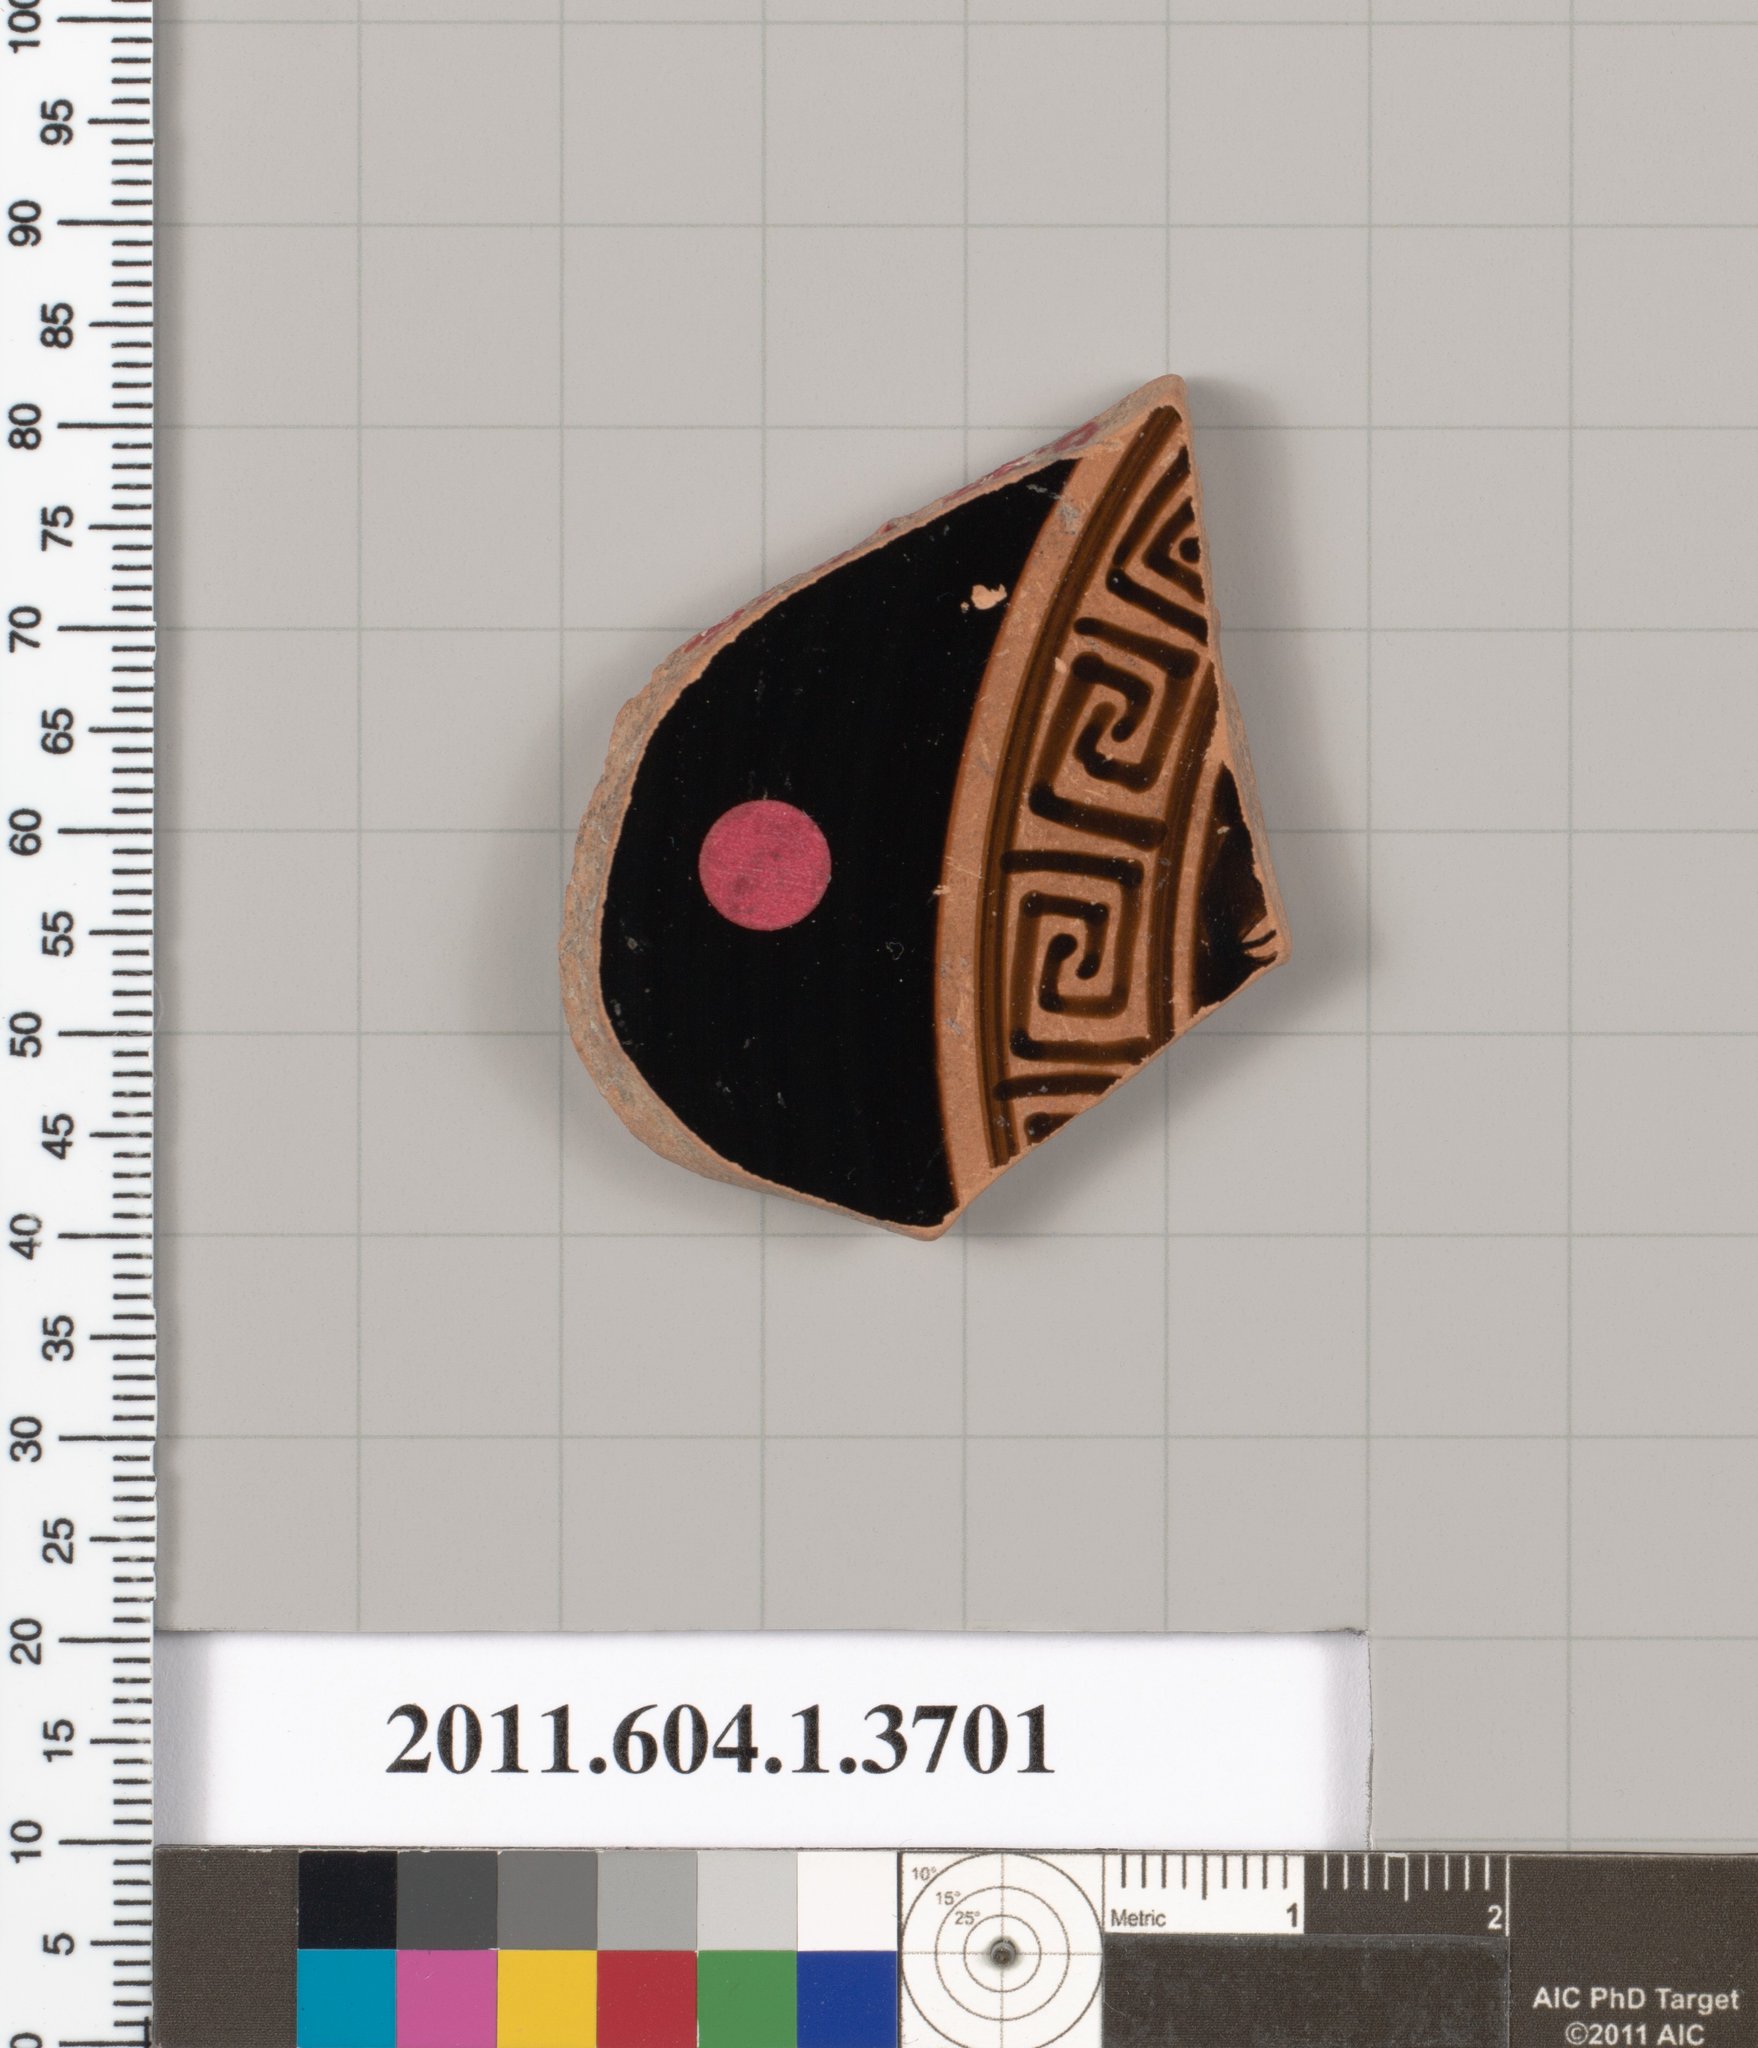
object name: kylix fragment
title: Terracotta fragment of a kylix (drinking cup)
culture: greek, attic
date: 500-480 BCE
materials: terracotta